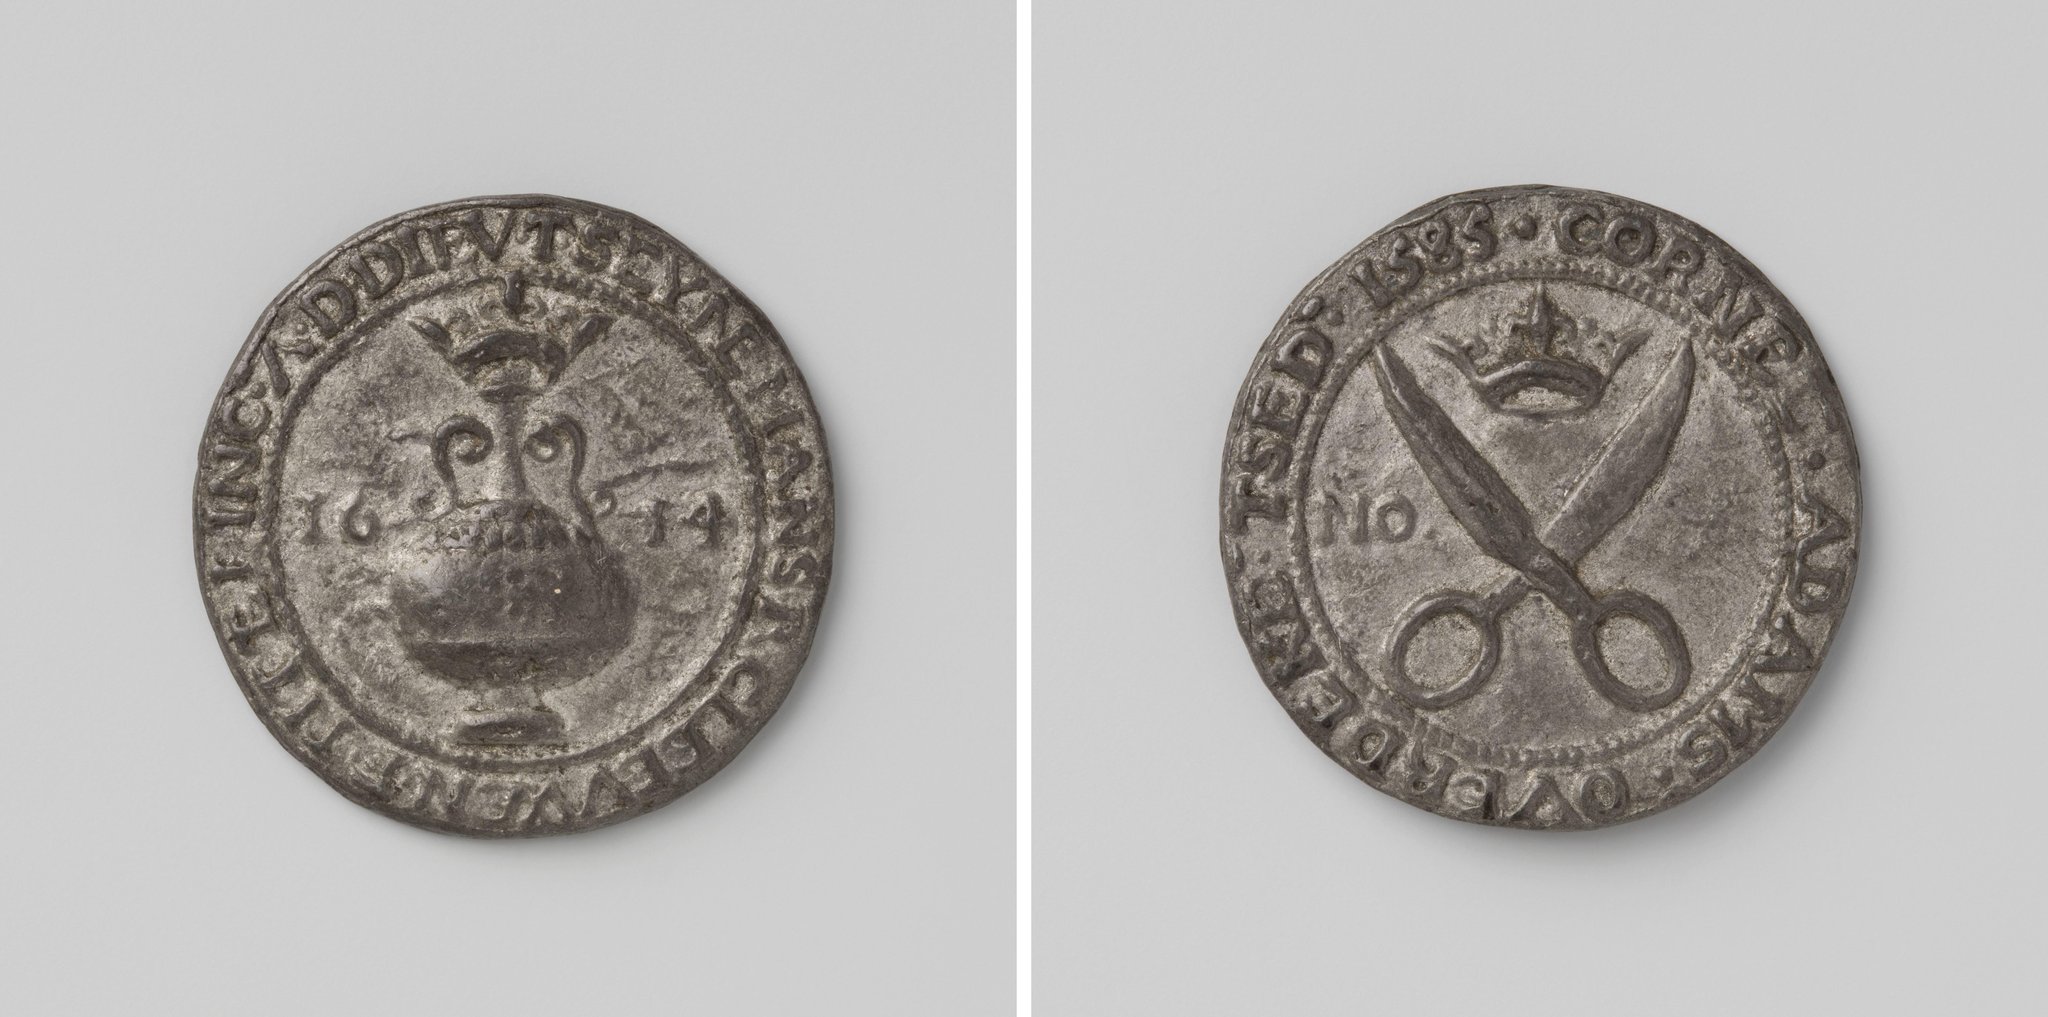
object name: medal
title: Kleermakersgilde van Vlissingen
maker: Anonymous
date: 1614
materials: lead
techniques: casting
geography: flushing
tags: flushing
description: Loden penning. Voorzijde: gekroonde fles tussen jaartal binnen omschrift. Keerzijde: gekroonde schaar naast opschrift No. binnen omschrift